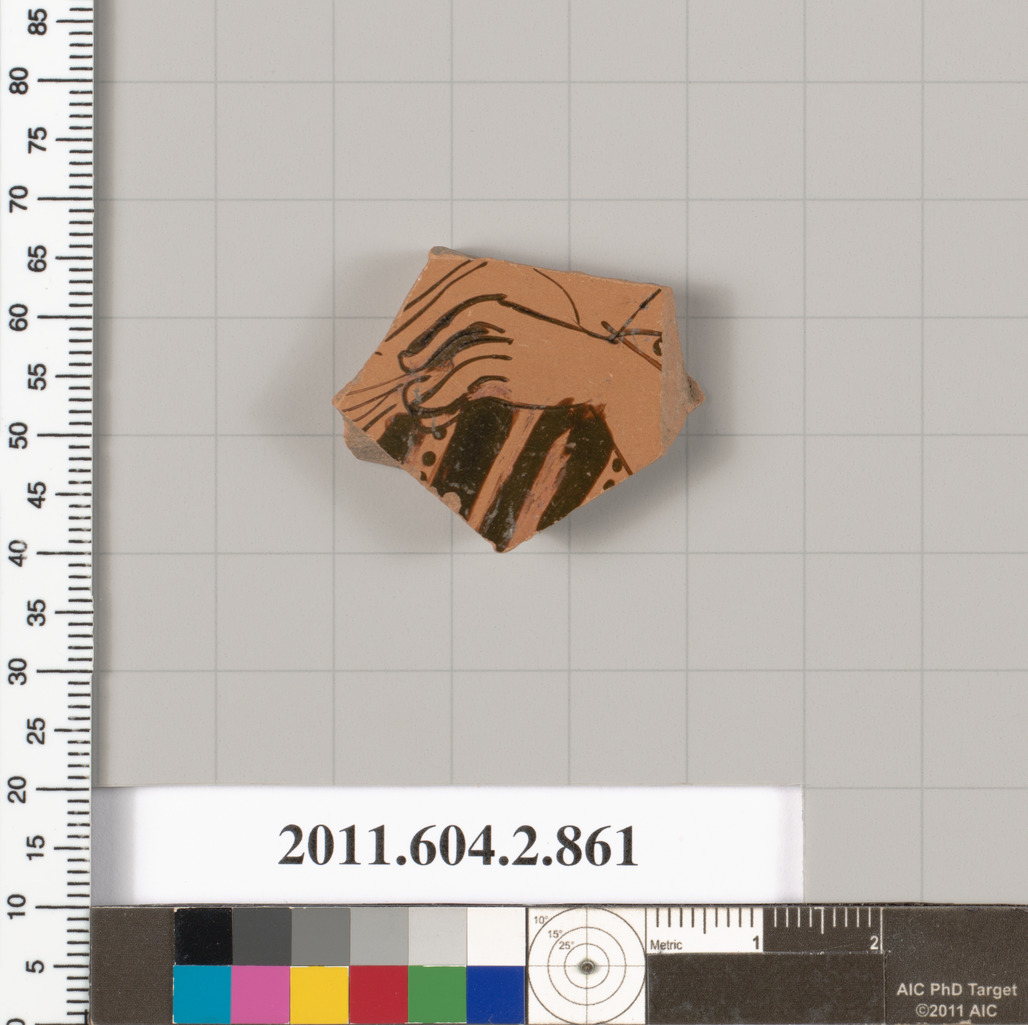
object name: bell krater fragment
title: Terracotta fragment of a bell-krater (bowl for mixing wine and water)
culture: greek, attic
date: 450-440 BCE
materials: terracotta